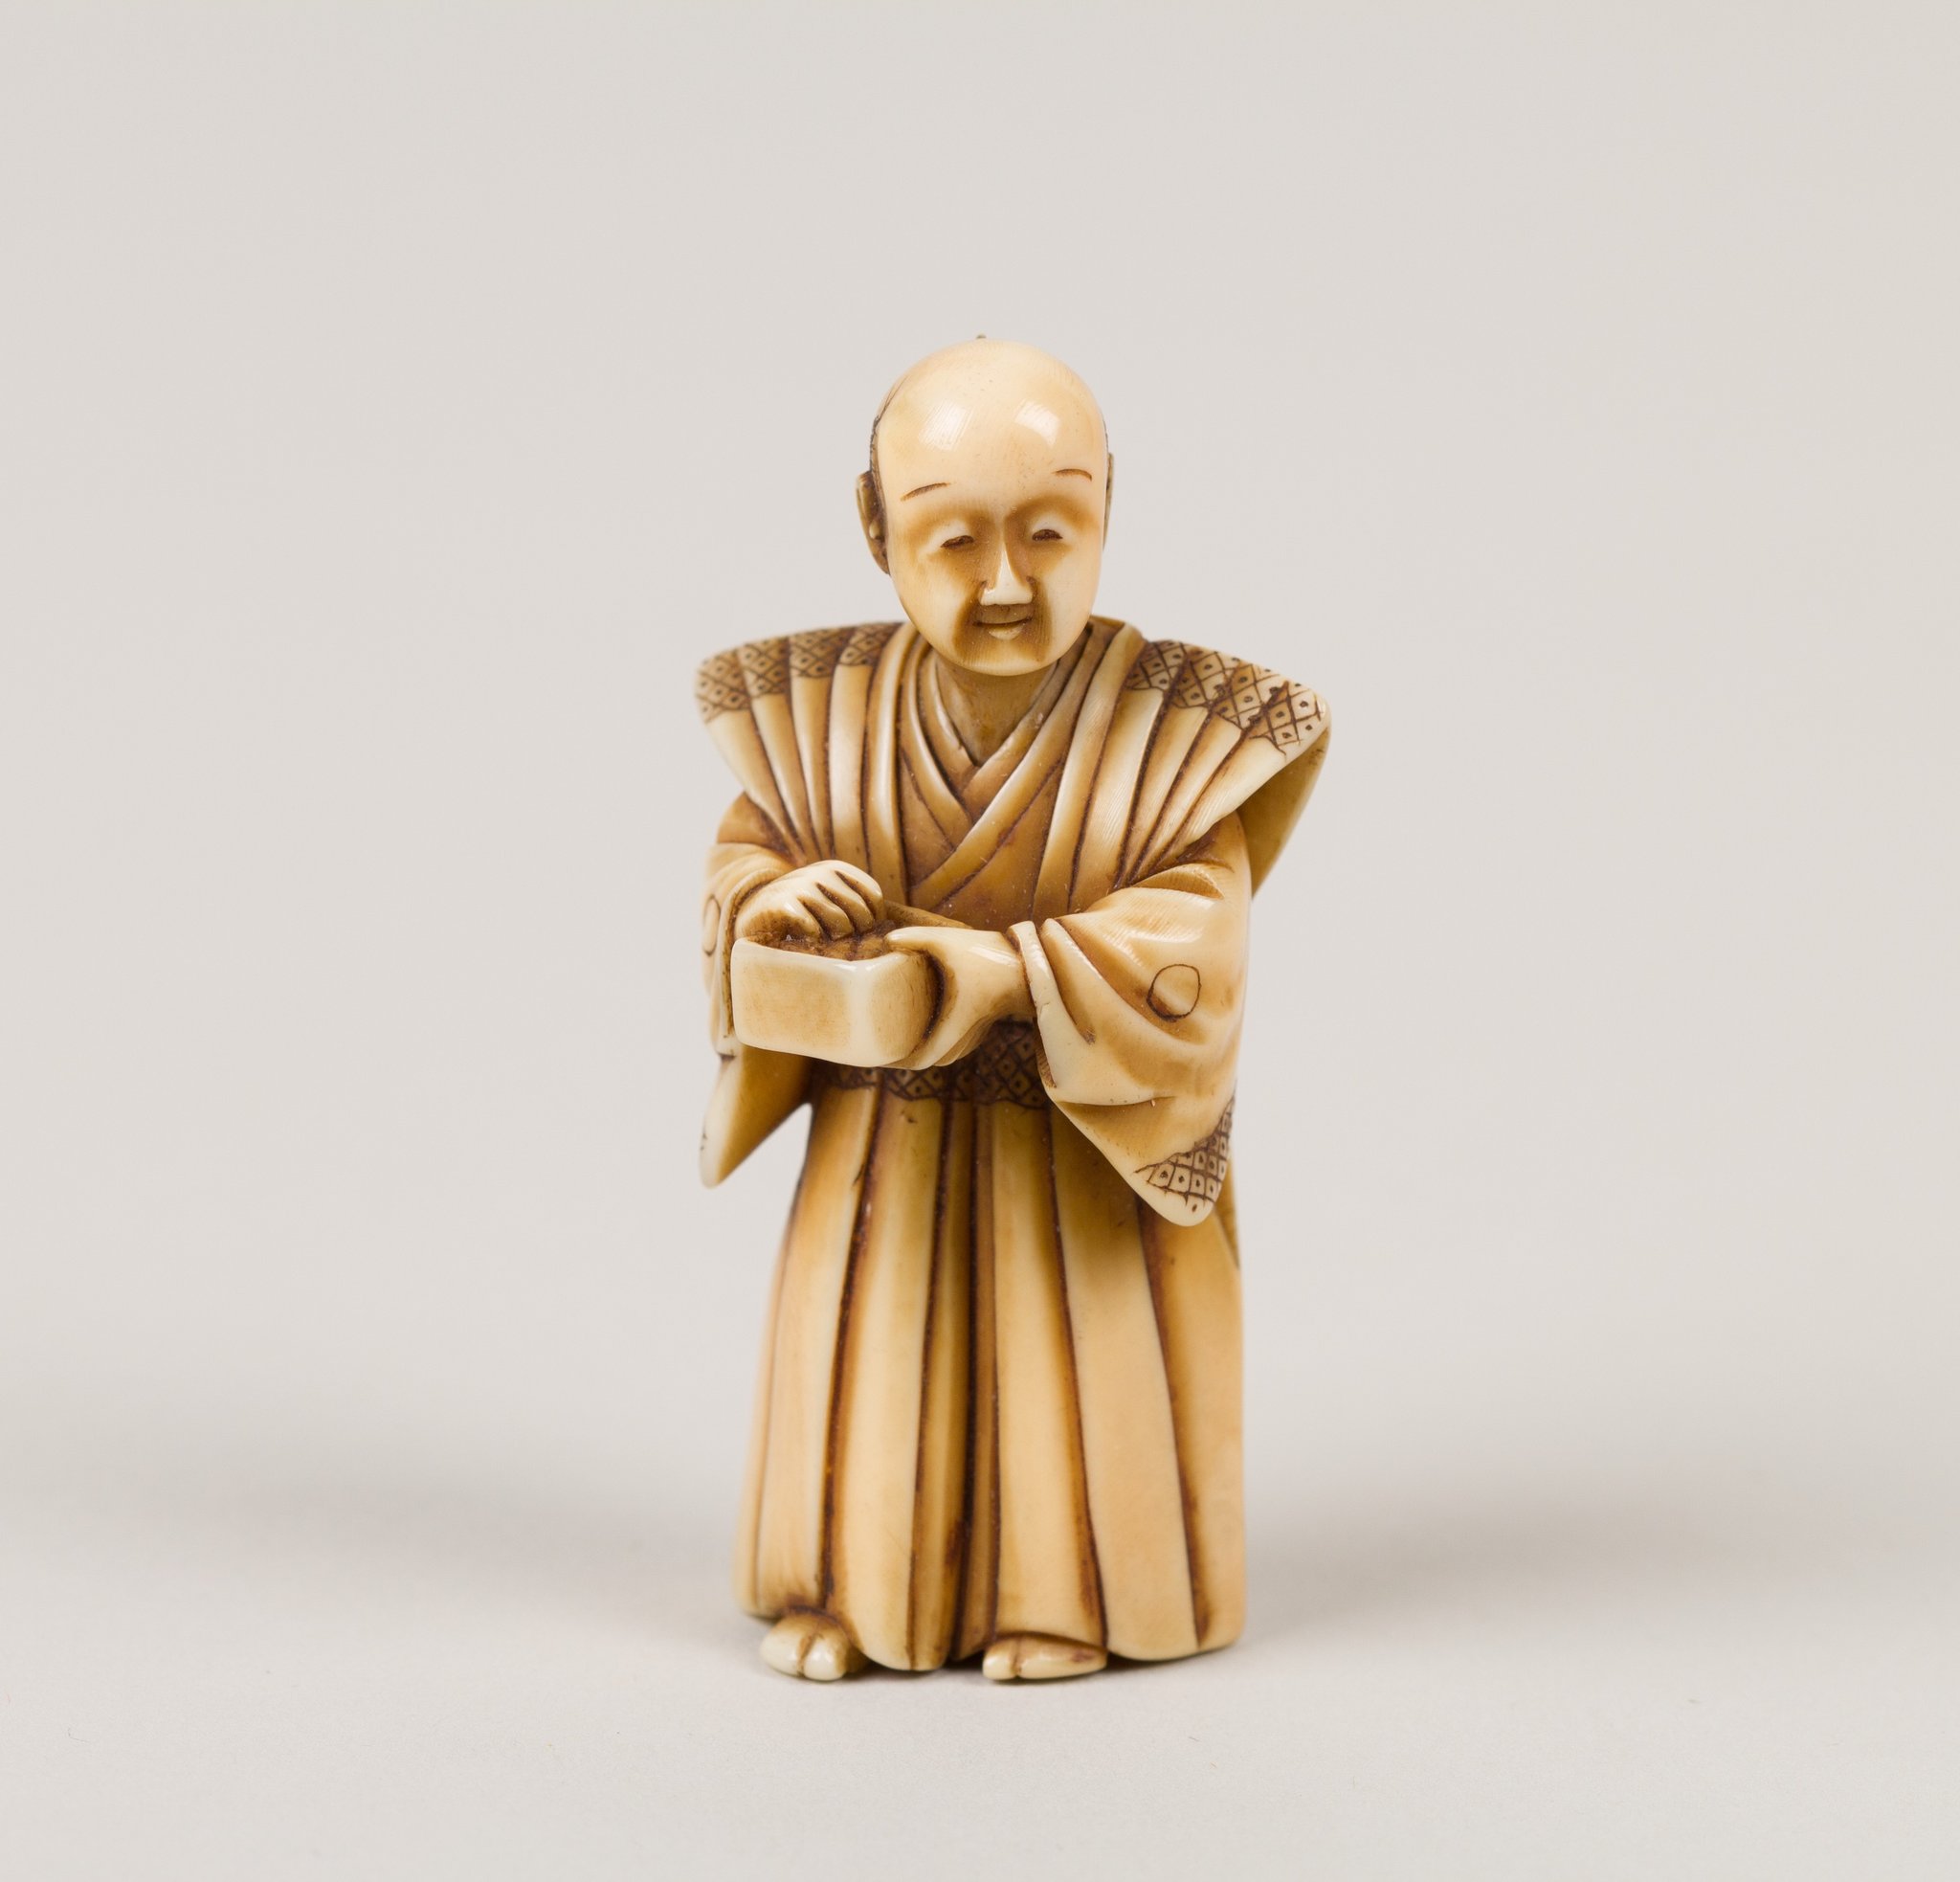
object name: netsuke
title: Netsuke of Priest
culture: japanese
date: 1801-1900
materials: ivory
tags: men,priests